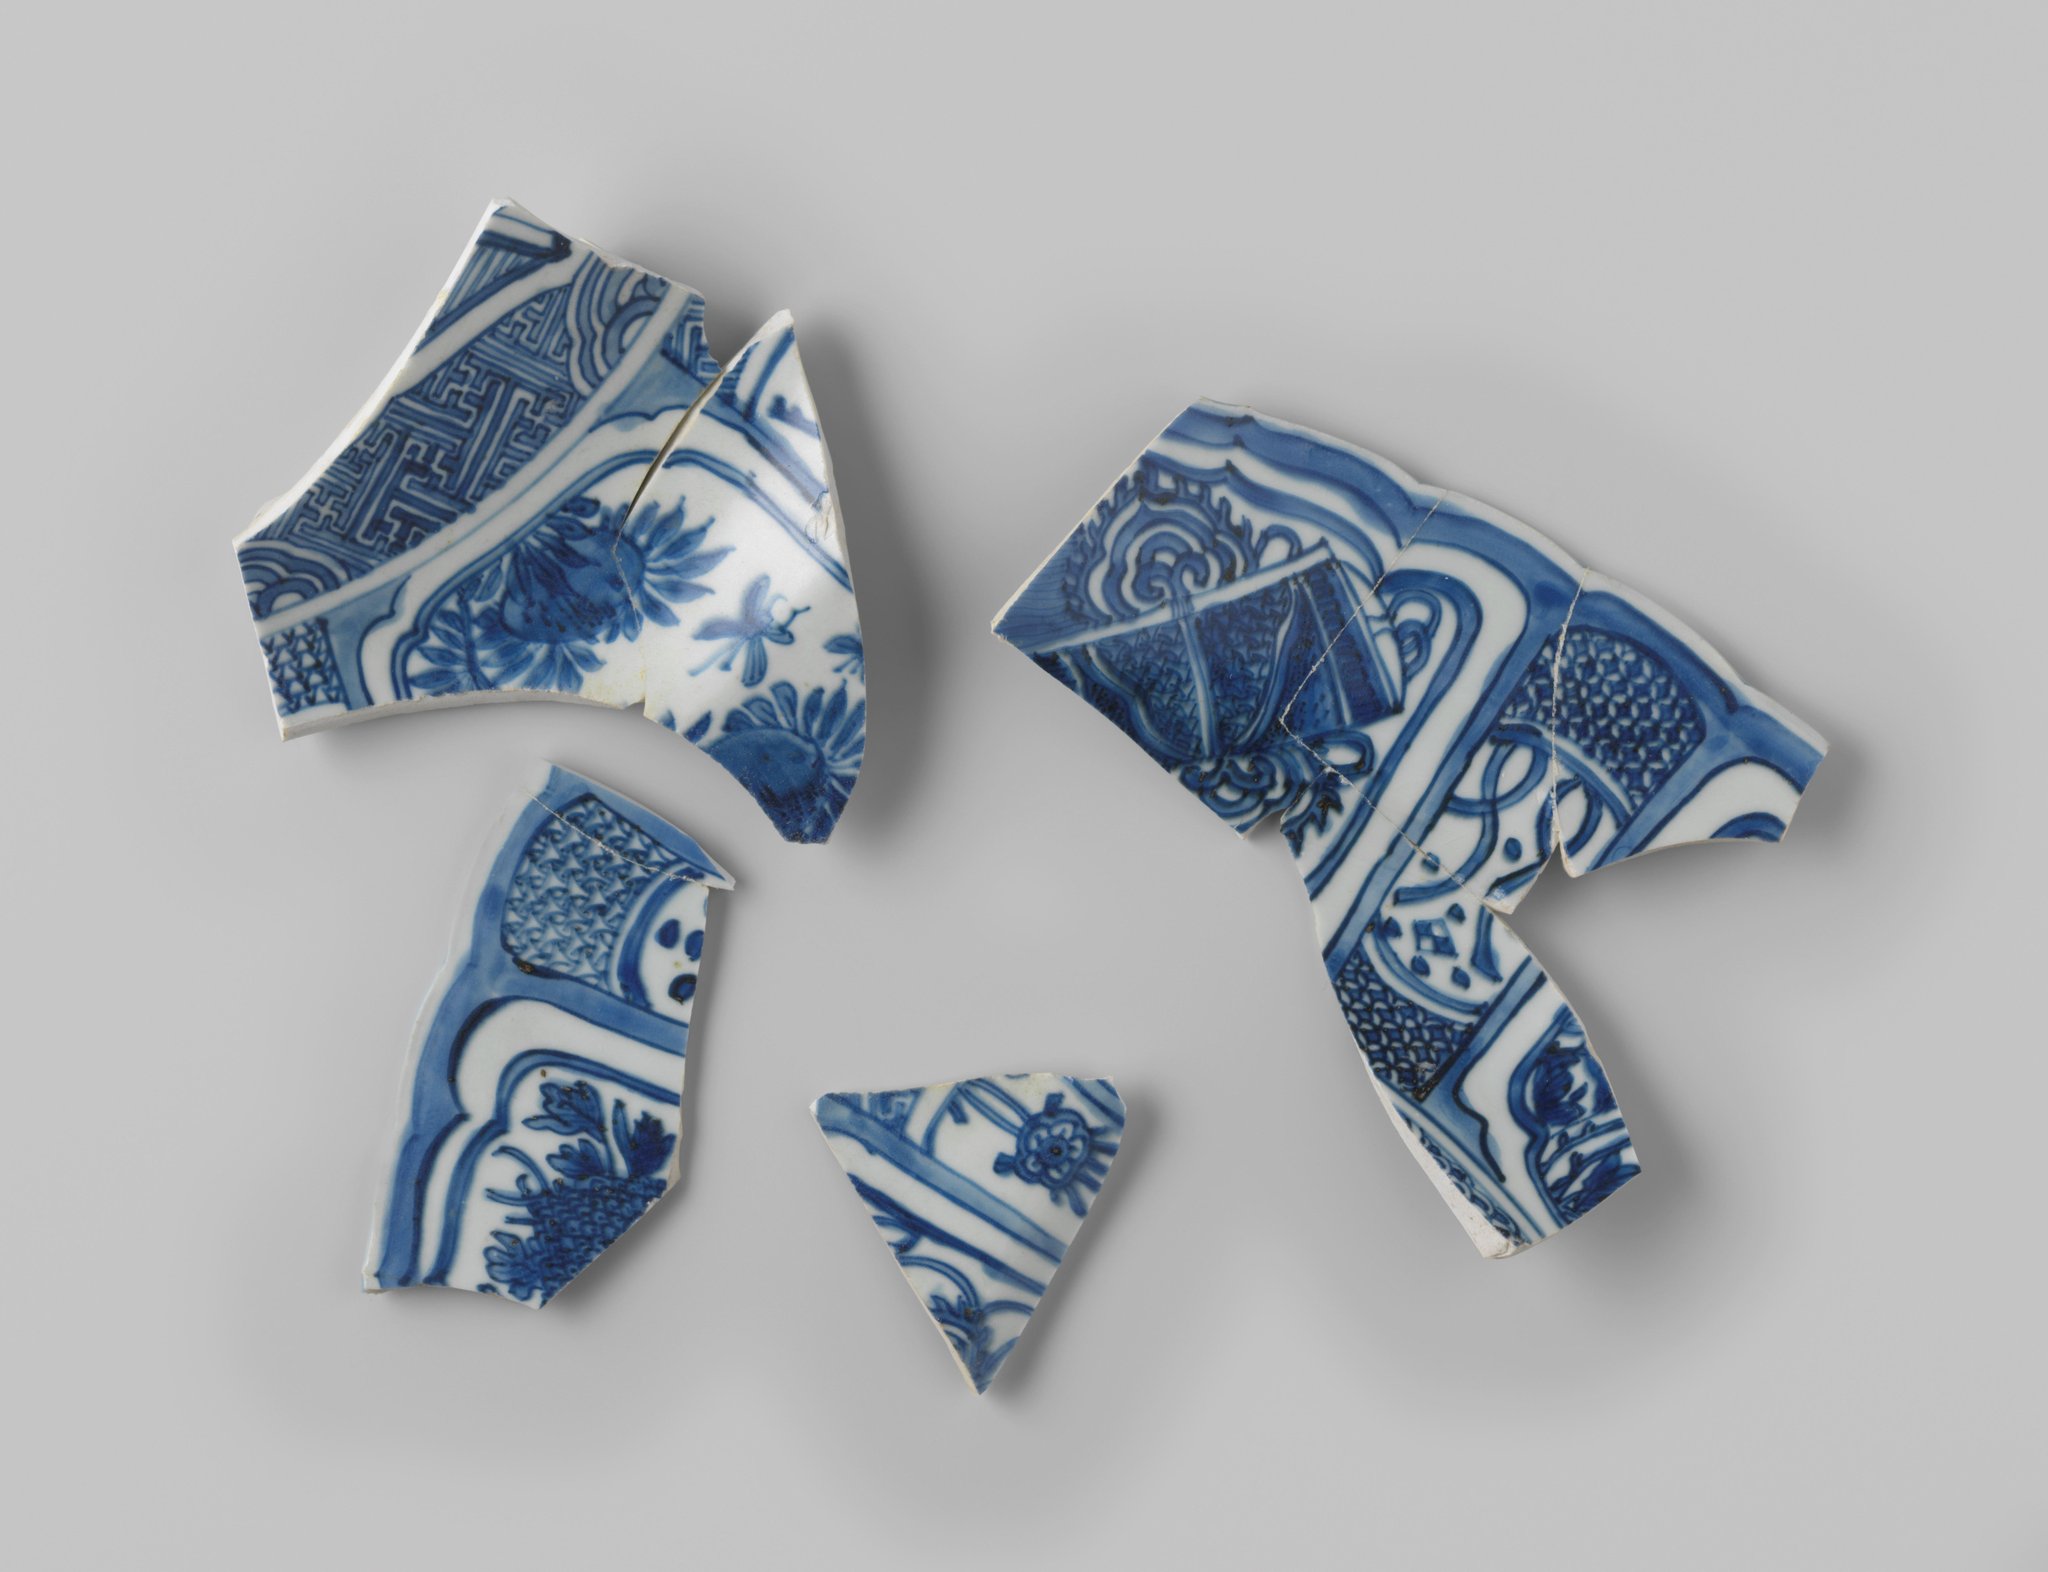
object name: platter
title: Large plate or 'lampetschotel' of Chinese porcelain from the wreck of the Dutch East Indiaman Witte Leeuw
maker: Anonymous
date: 1613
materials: bone china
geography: jingdezhen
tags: verenigde oostindische compagnie, sint-helena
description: A large plate with a flattened rim. A scalloped medallion with rui heads within concentric bands filled with alternating diaper patterns. A central decoration of waterfowl near a peony and lotus. Panels decorated with flowers, fruits and symbols.